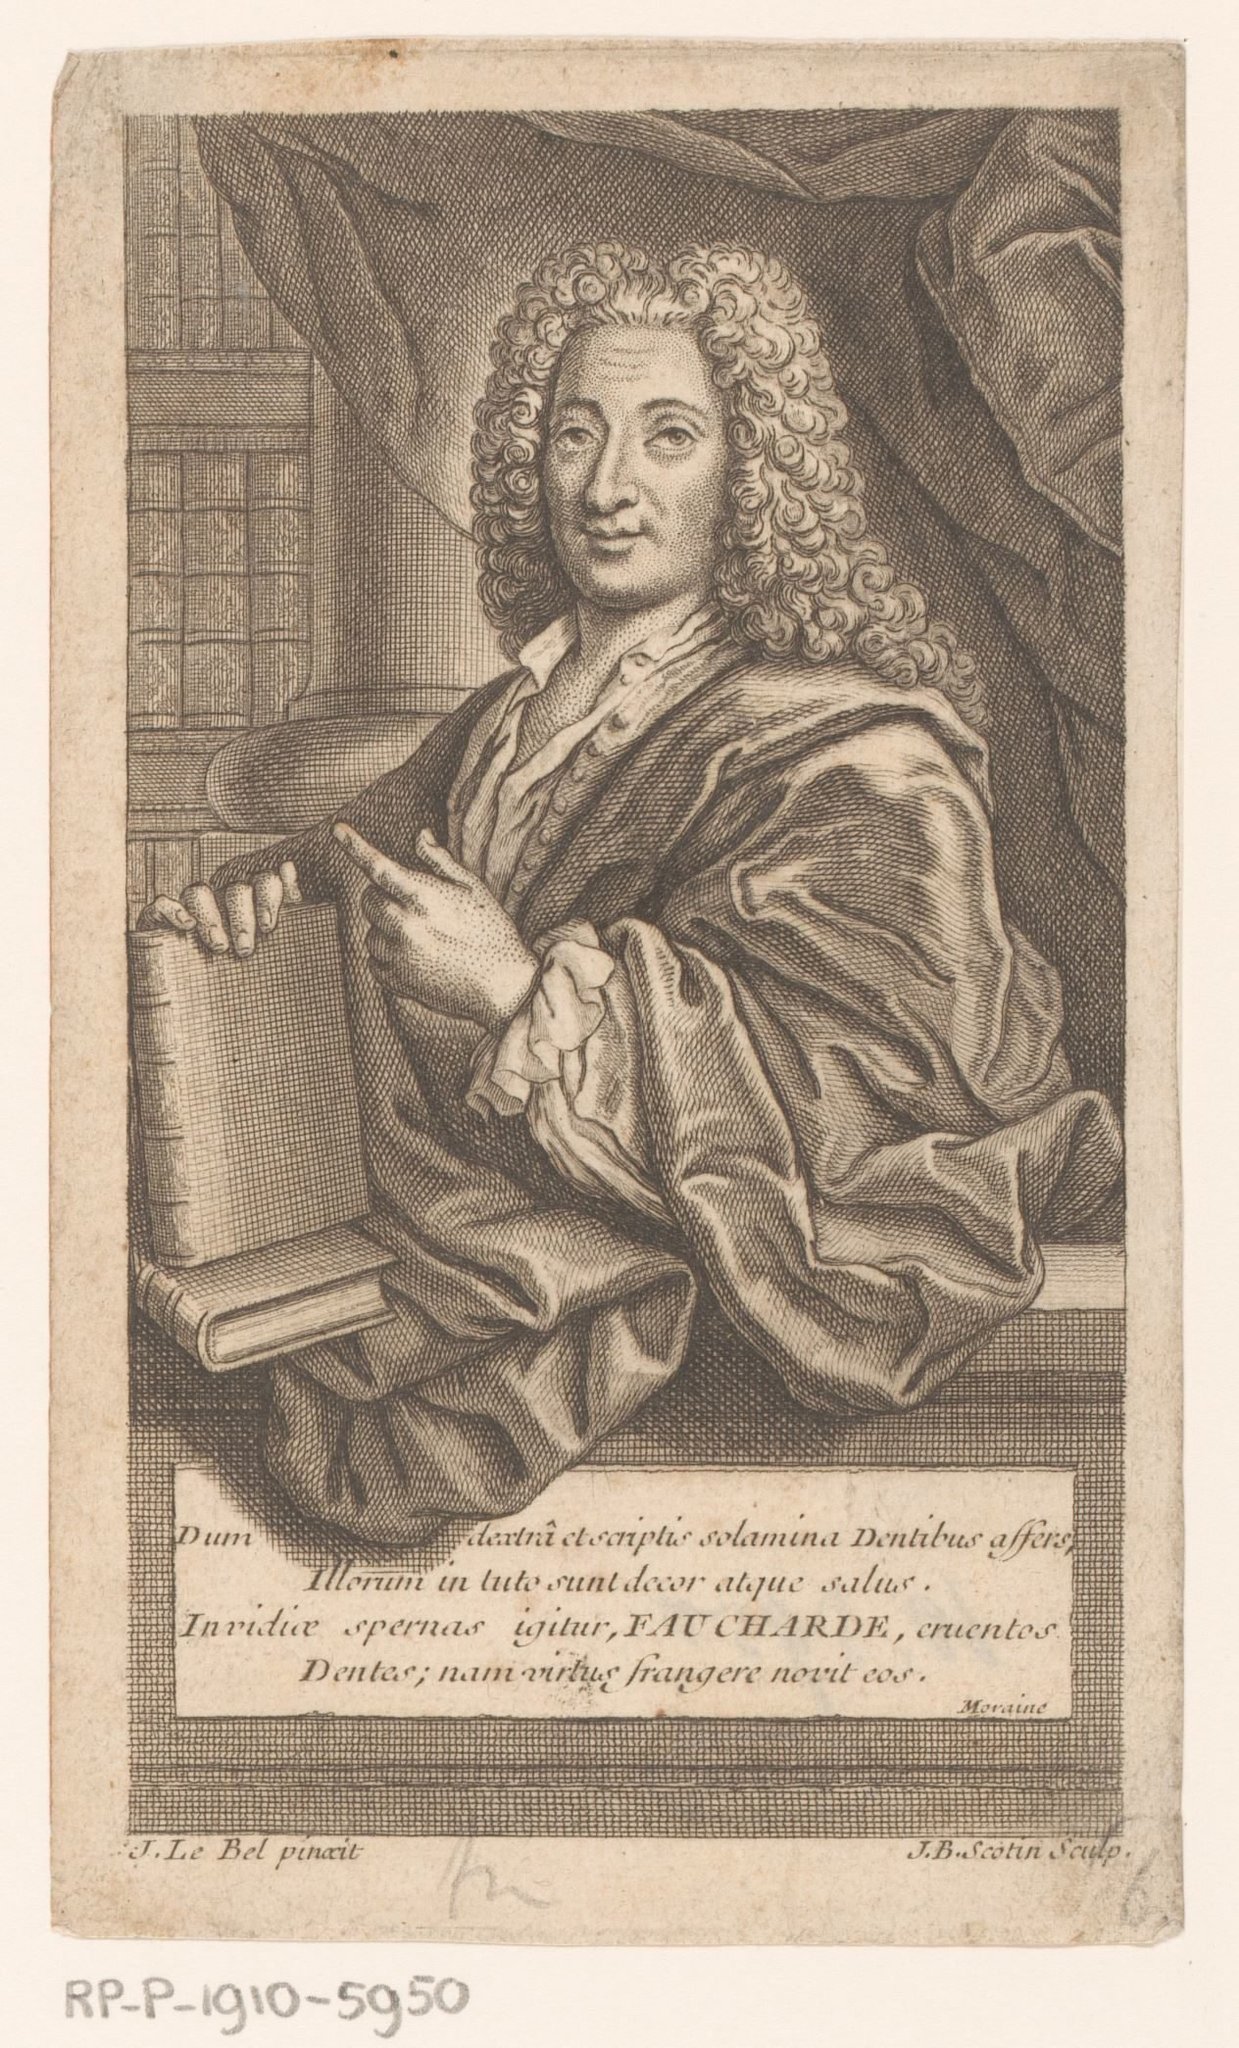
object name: print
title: Portret van Pierre Fauchard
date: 1688-1733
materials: paper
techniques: engraving, etching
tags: paris, historical persons, physician, doctor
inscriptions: collector's mark: Lugt 2228